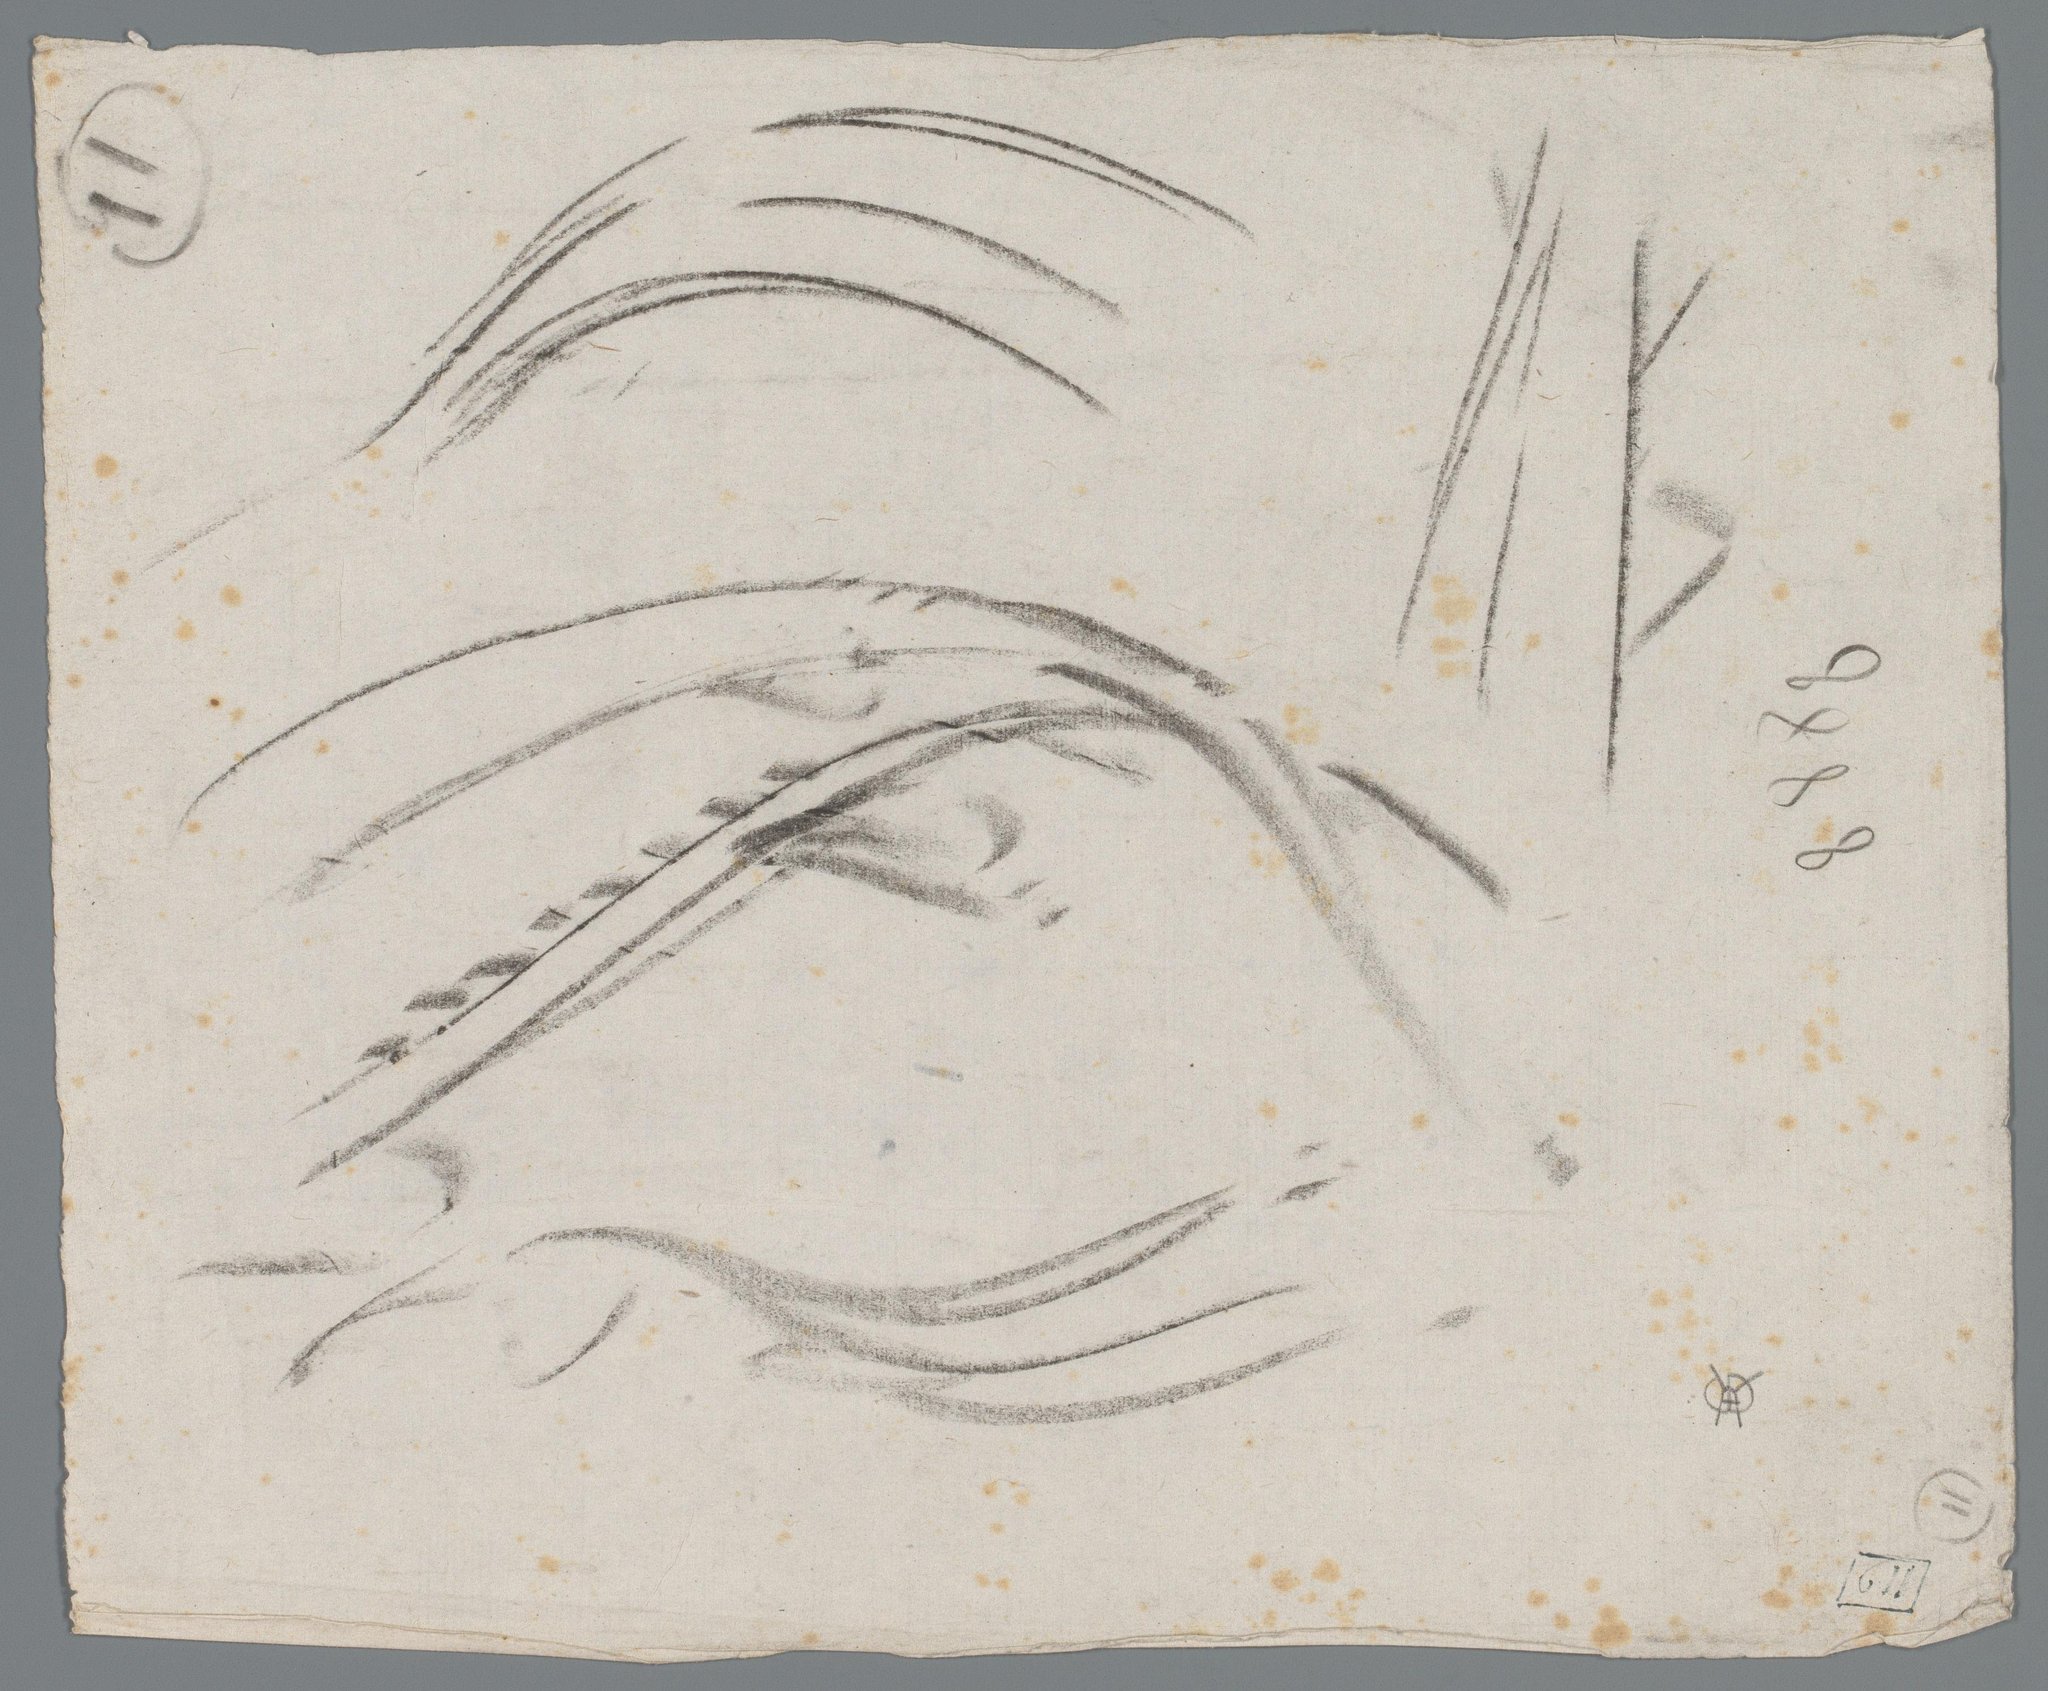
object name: drawing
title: Studie van een vissenstaart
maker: gerrit willem dijsselhof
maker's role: designer, draughtsman, print maker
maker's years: 1866-1924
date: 1876-1924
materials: chalk, paper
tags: bony fishes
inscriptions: number: ‘611’, number: ‘11’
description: Mogelijk van een steur. Met op verso een schets.